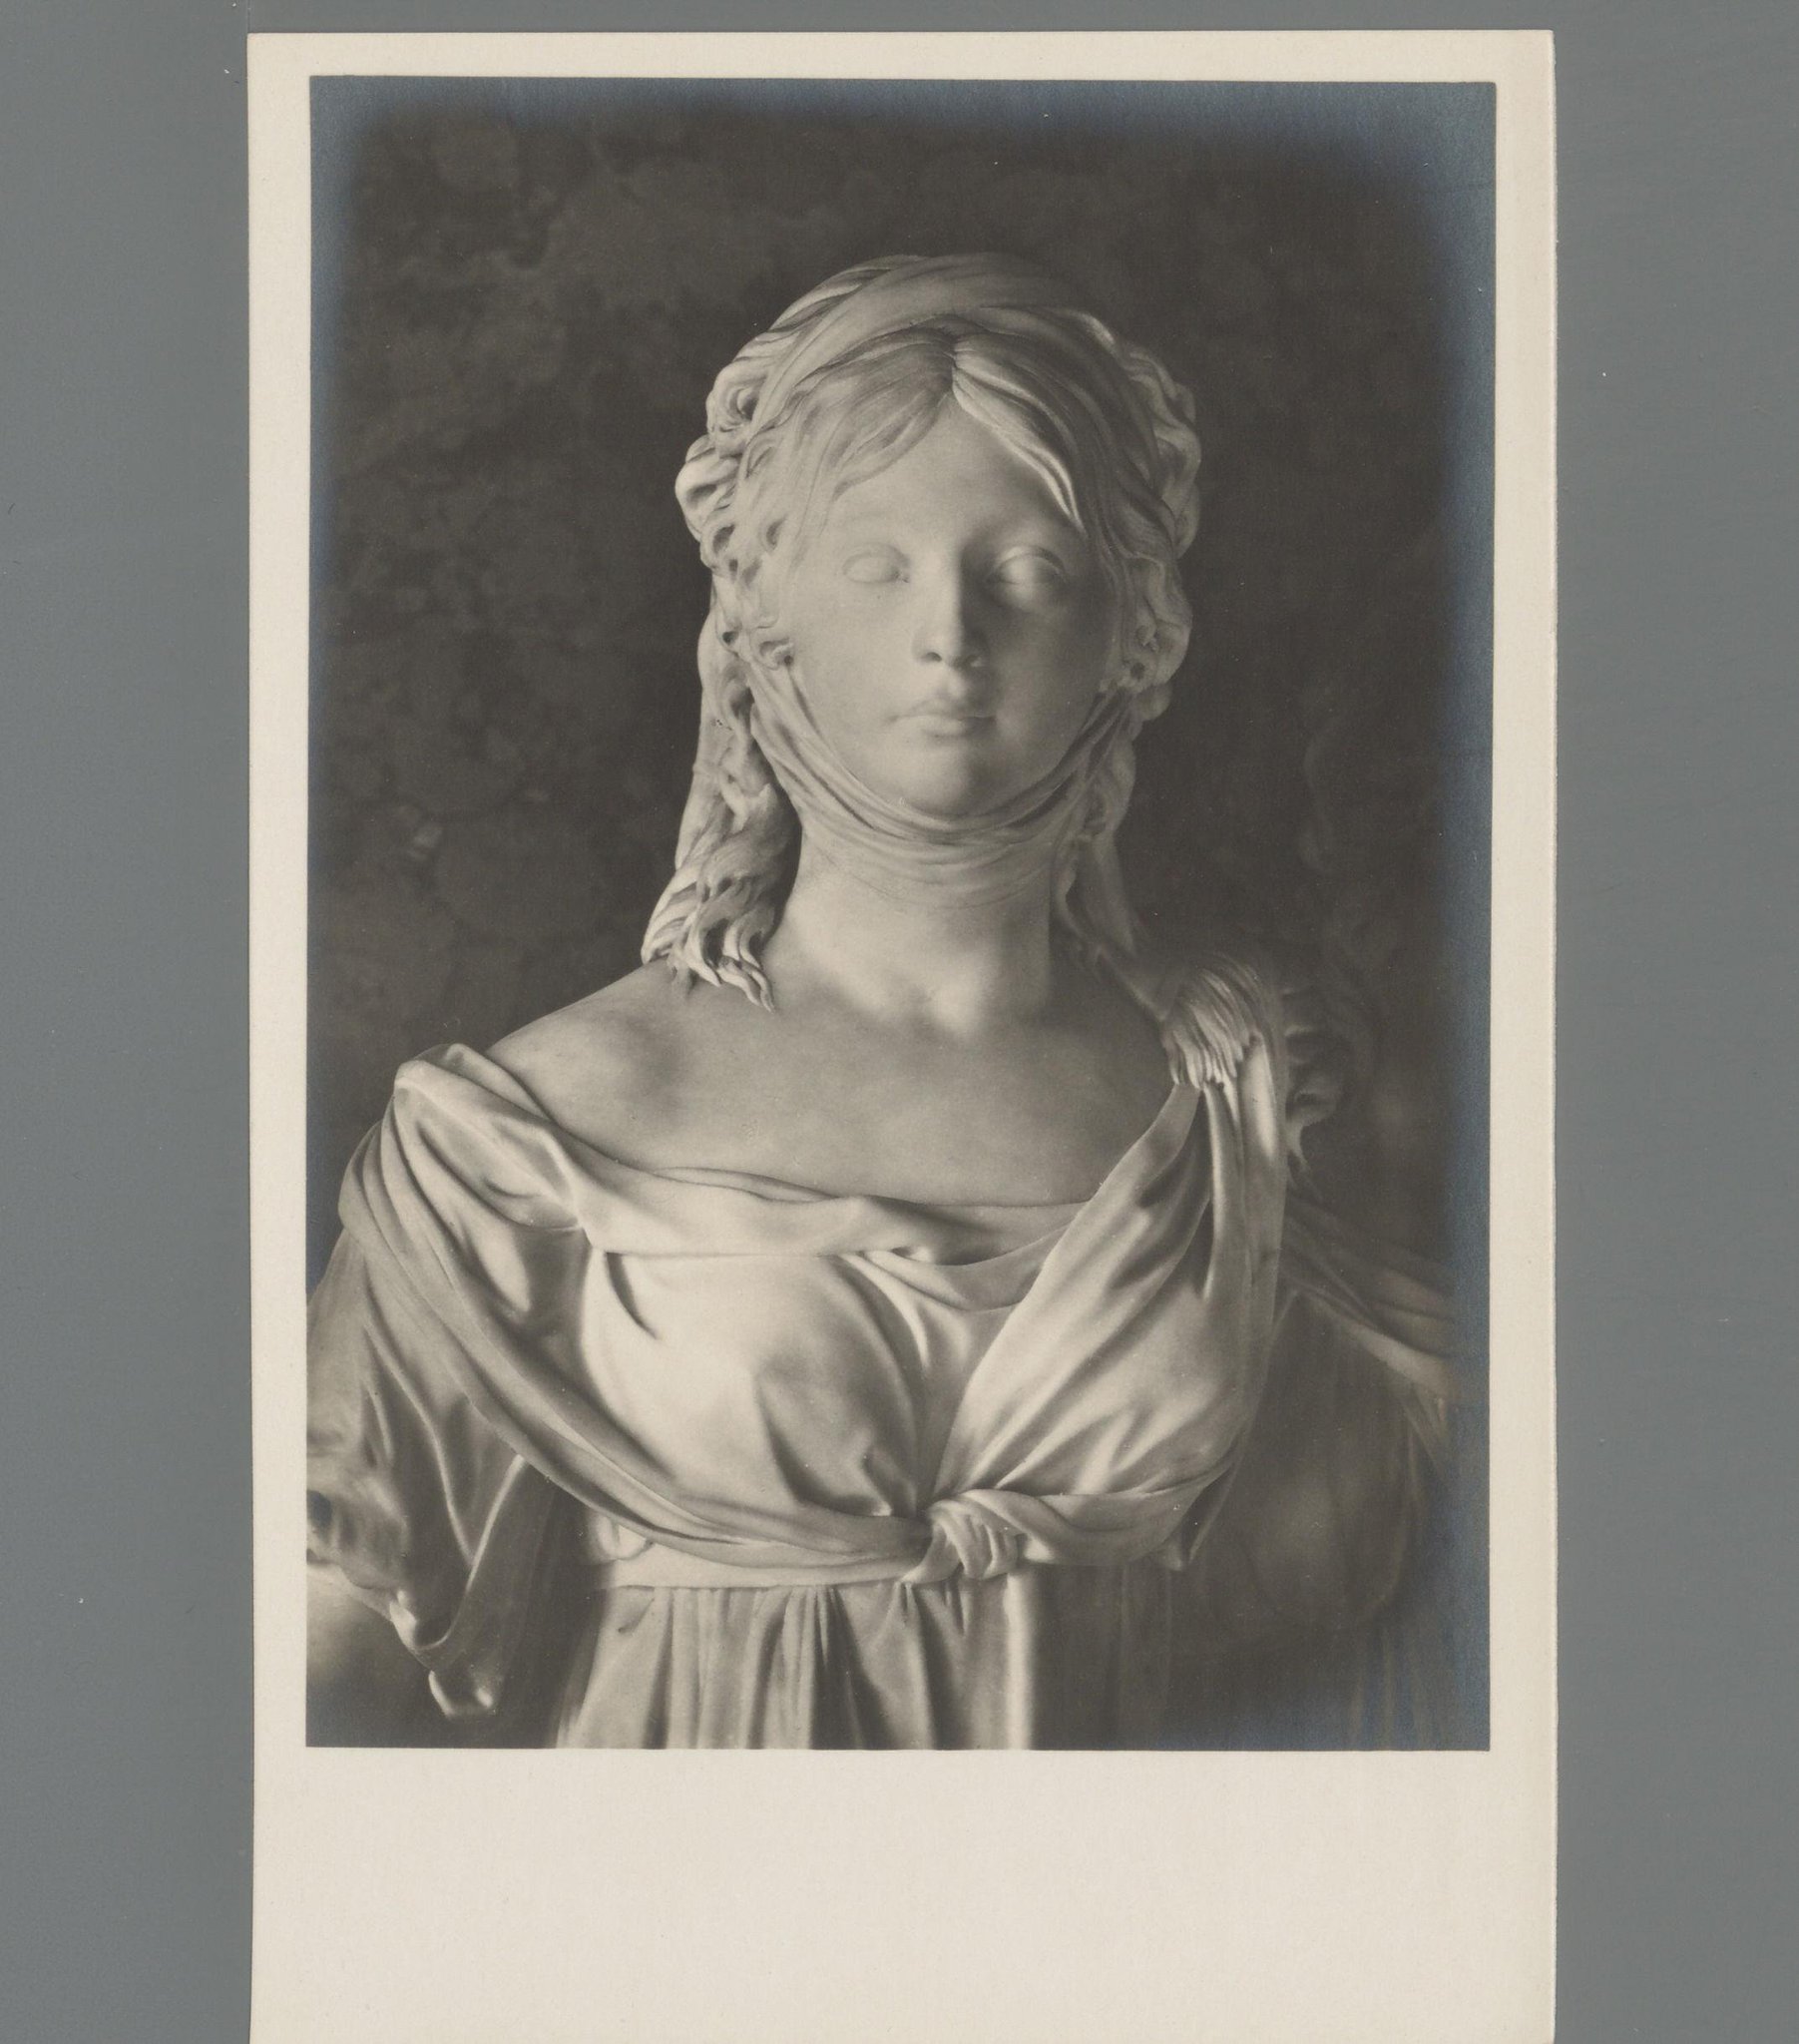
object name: photograph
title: Schlossmuseum Berlin. Gottfried Schadow (1764-1850). Kronprinzessin Luise. 1795 (Ausschnitt)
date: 1918-1930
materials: photographic support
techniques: photography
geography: berlin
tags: castle, statues, paintings, etc. ~ objects of worship in roman religion, permanent exhibition, museum